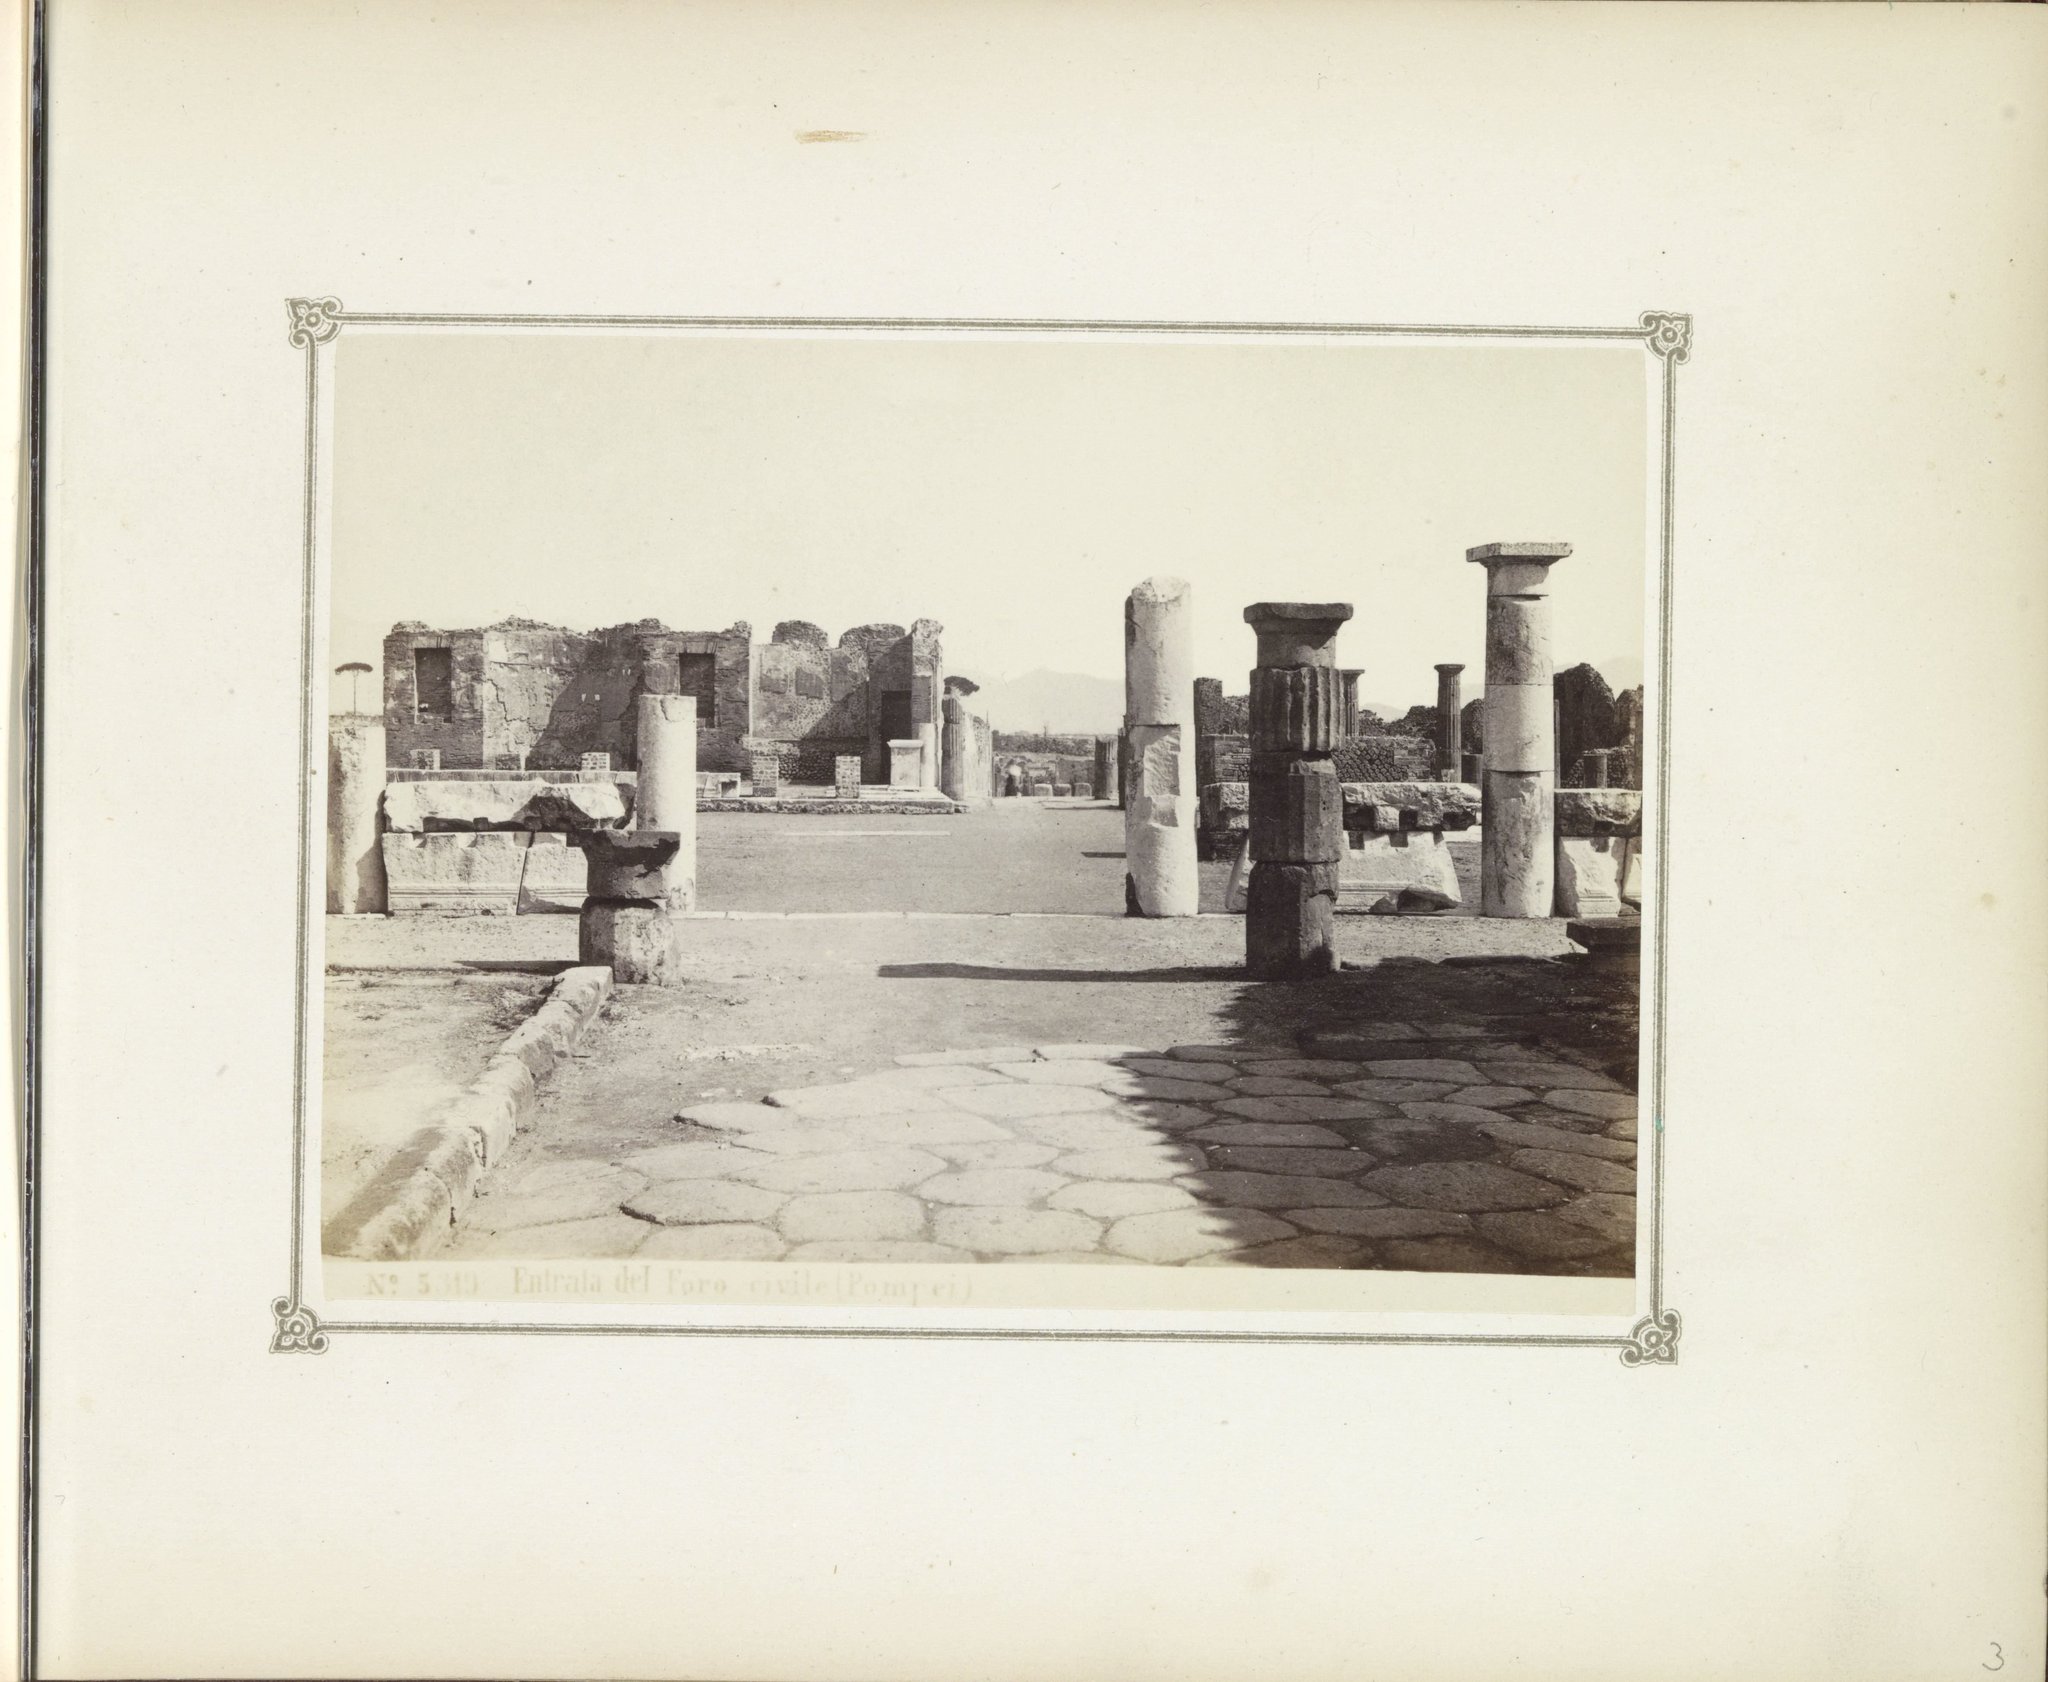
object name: album leaf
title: Entrata del Foro civile (Pompei)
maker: giorgio sommer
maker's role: fotograaf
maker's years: 1834-1914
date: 1860-1900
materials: paper, photographic support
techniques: albumen print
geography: pompeii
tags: square, place, circus, etc., gate, entrance, excavation ~ archaeology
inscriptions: number: ‘5319’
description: Onderdeel van Fotoalbum met opnames van opgravingen in Pompeï door Giorgio Sommer.